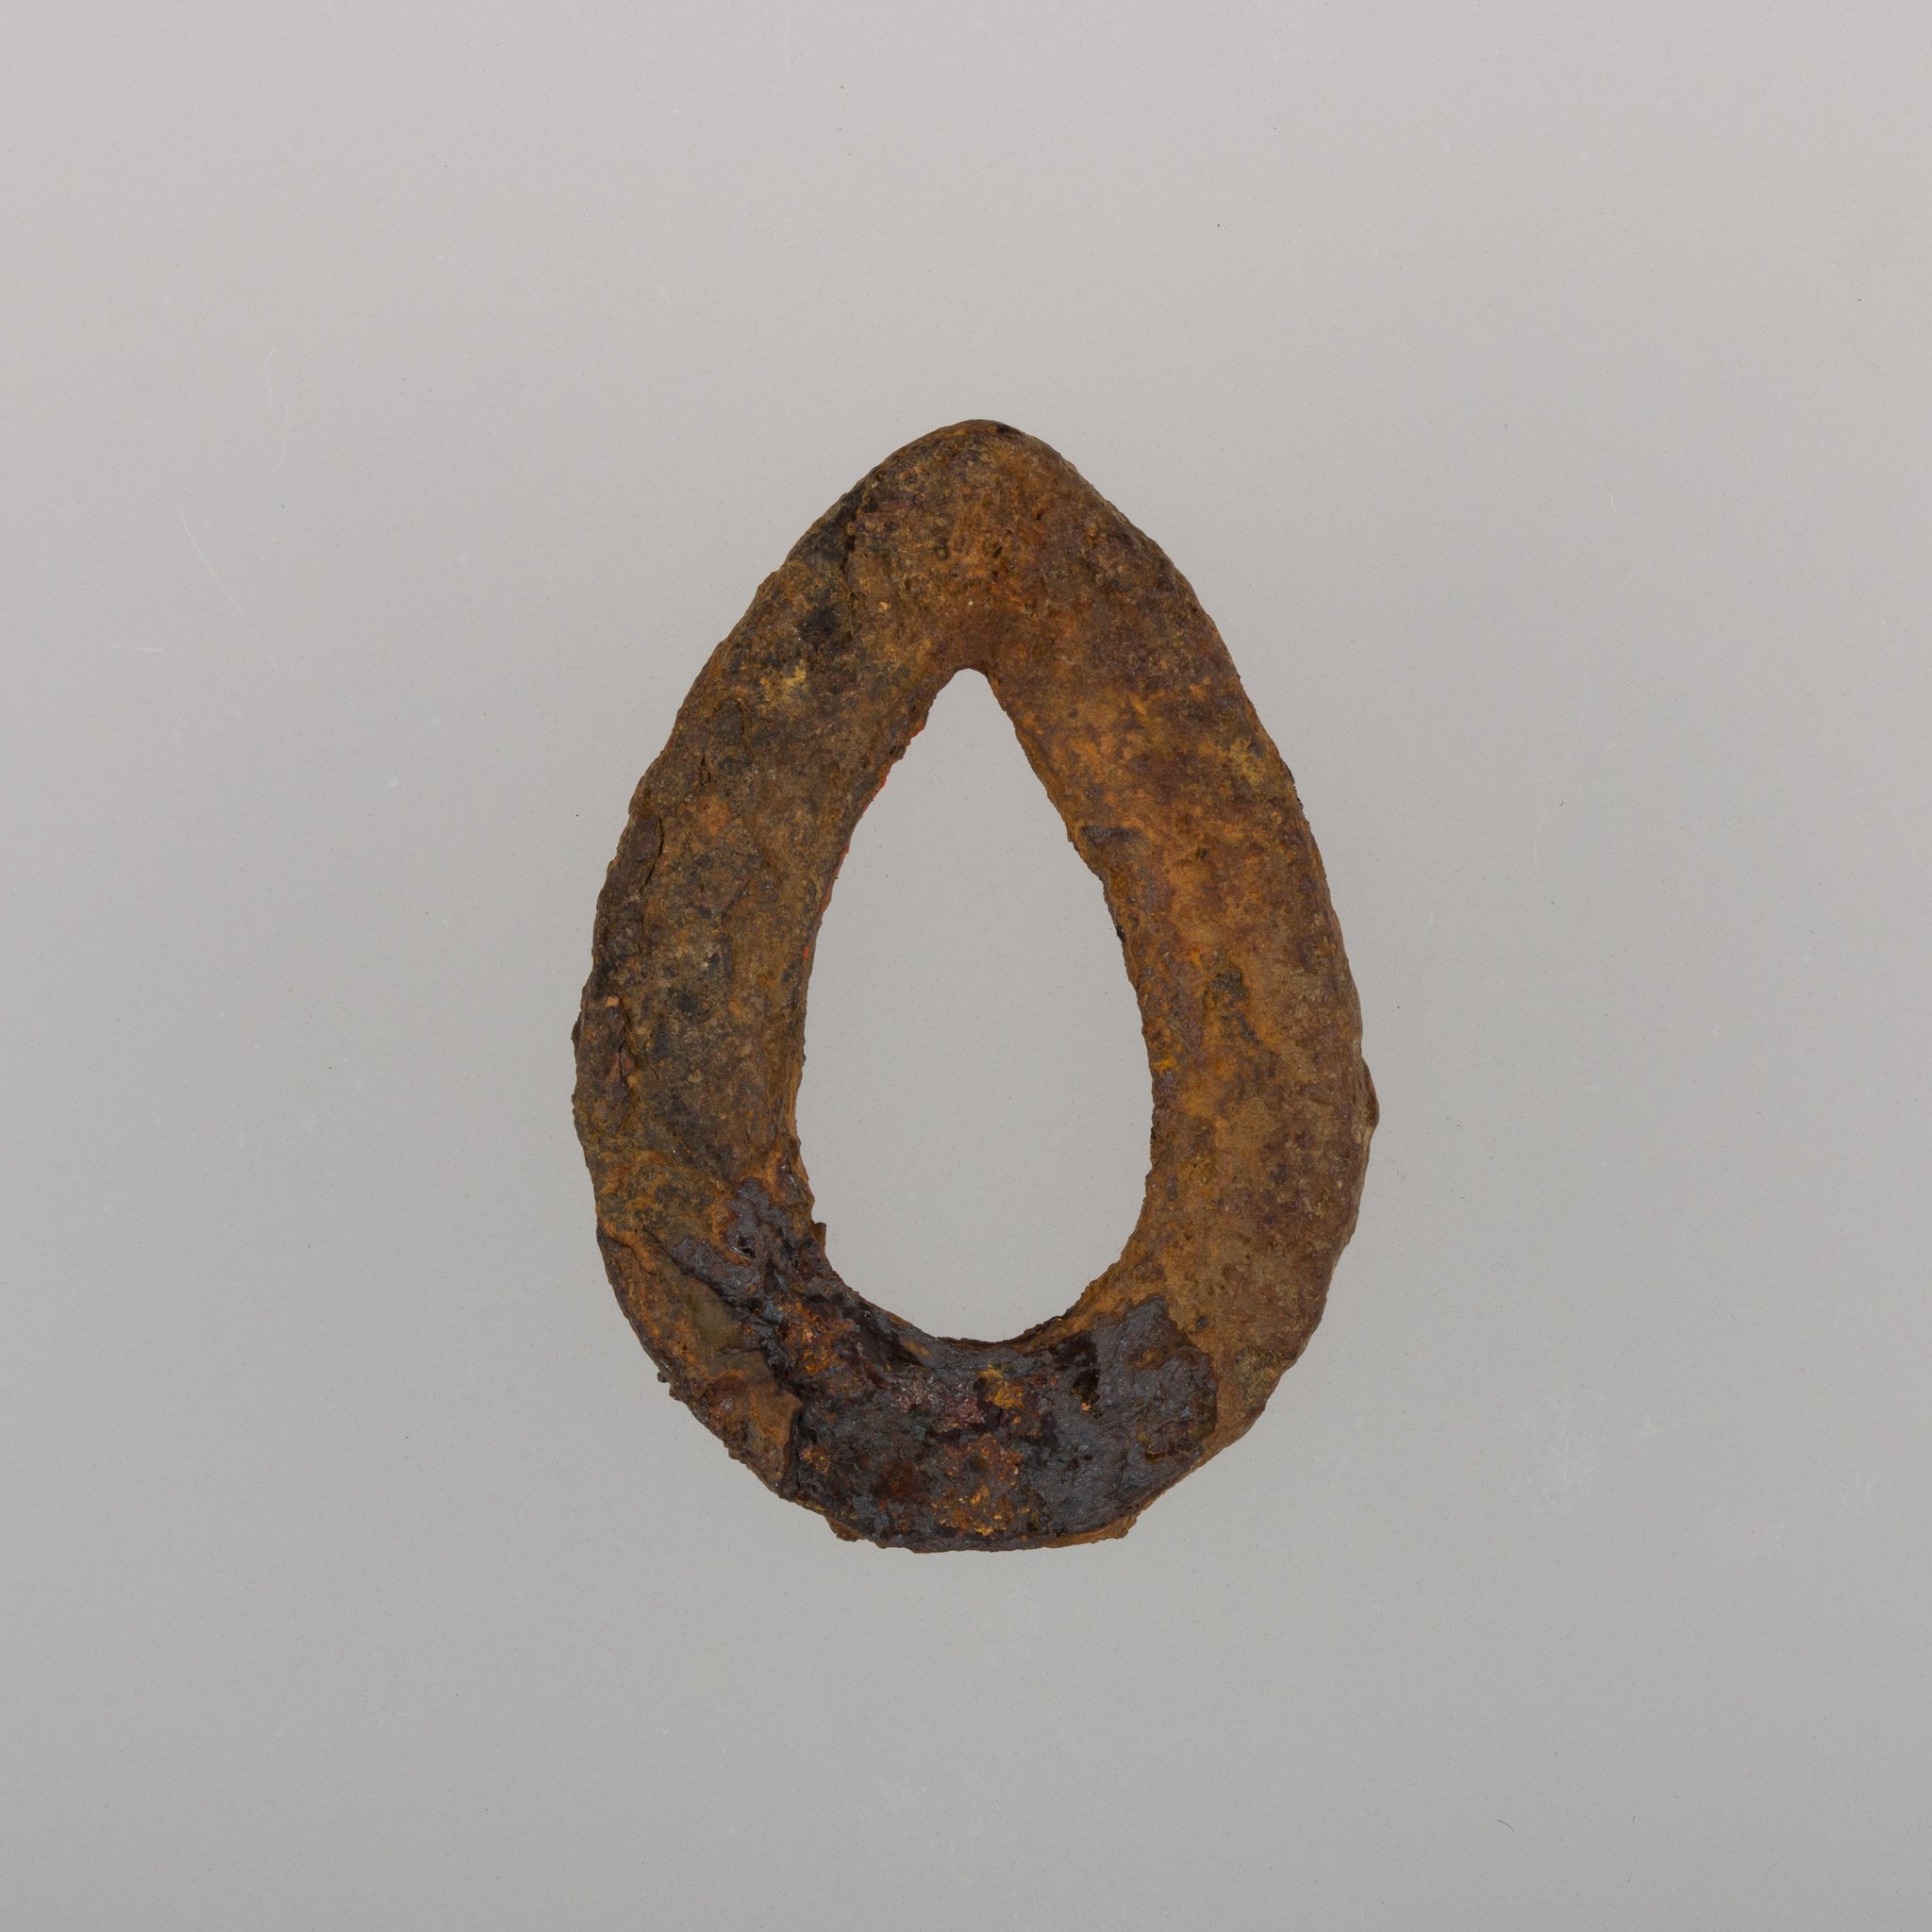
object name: sword guard tsuba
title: Sword Guard (Tsuba)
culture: japanese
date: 201-300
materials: iron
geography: japan